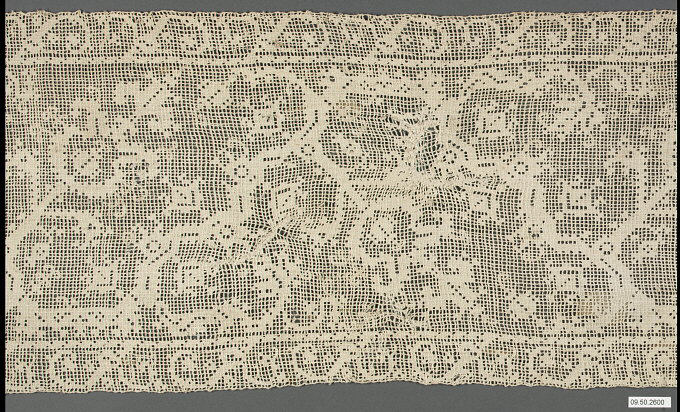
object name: strip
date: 1501-1600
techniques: embroidery